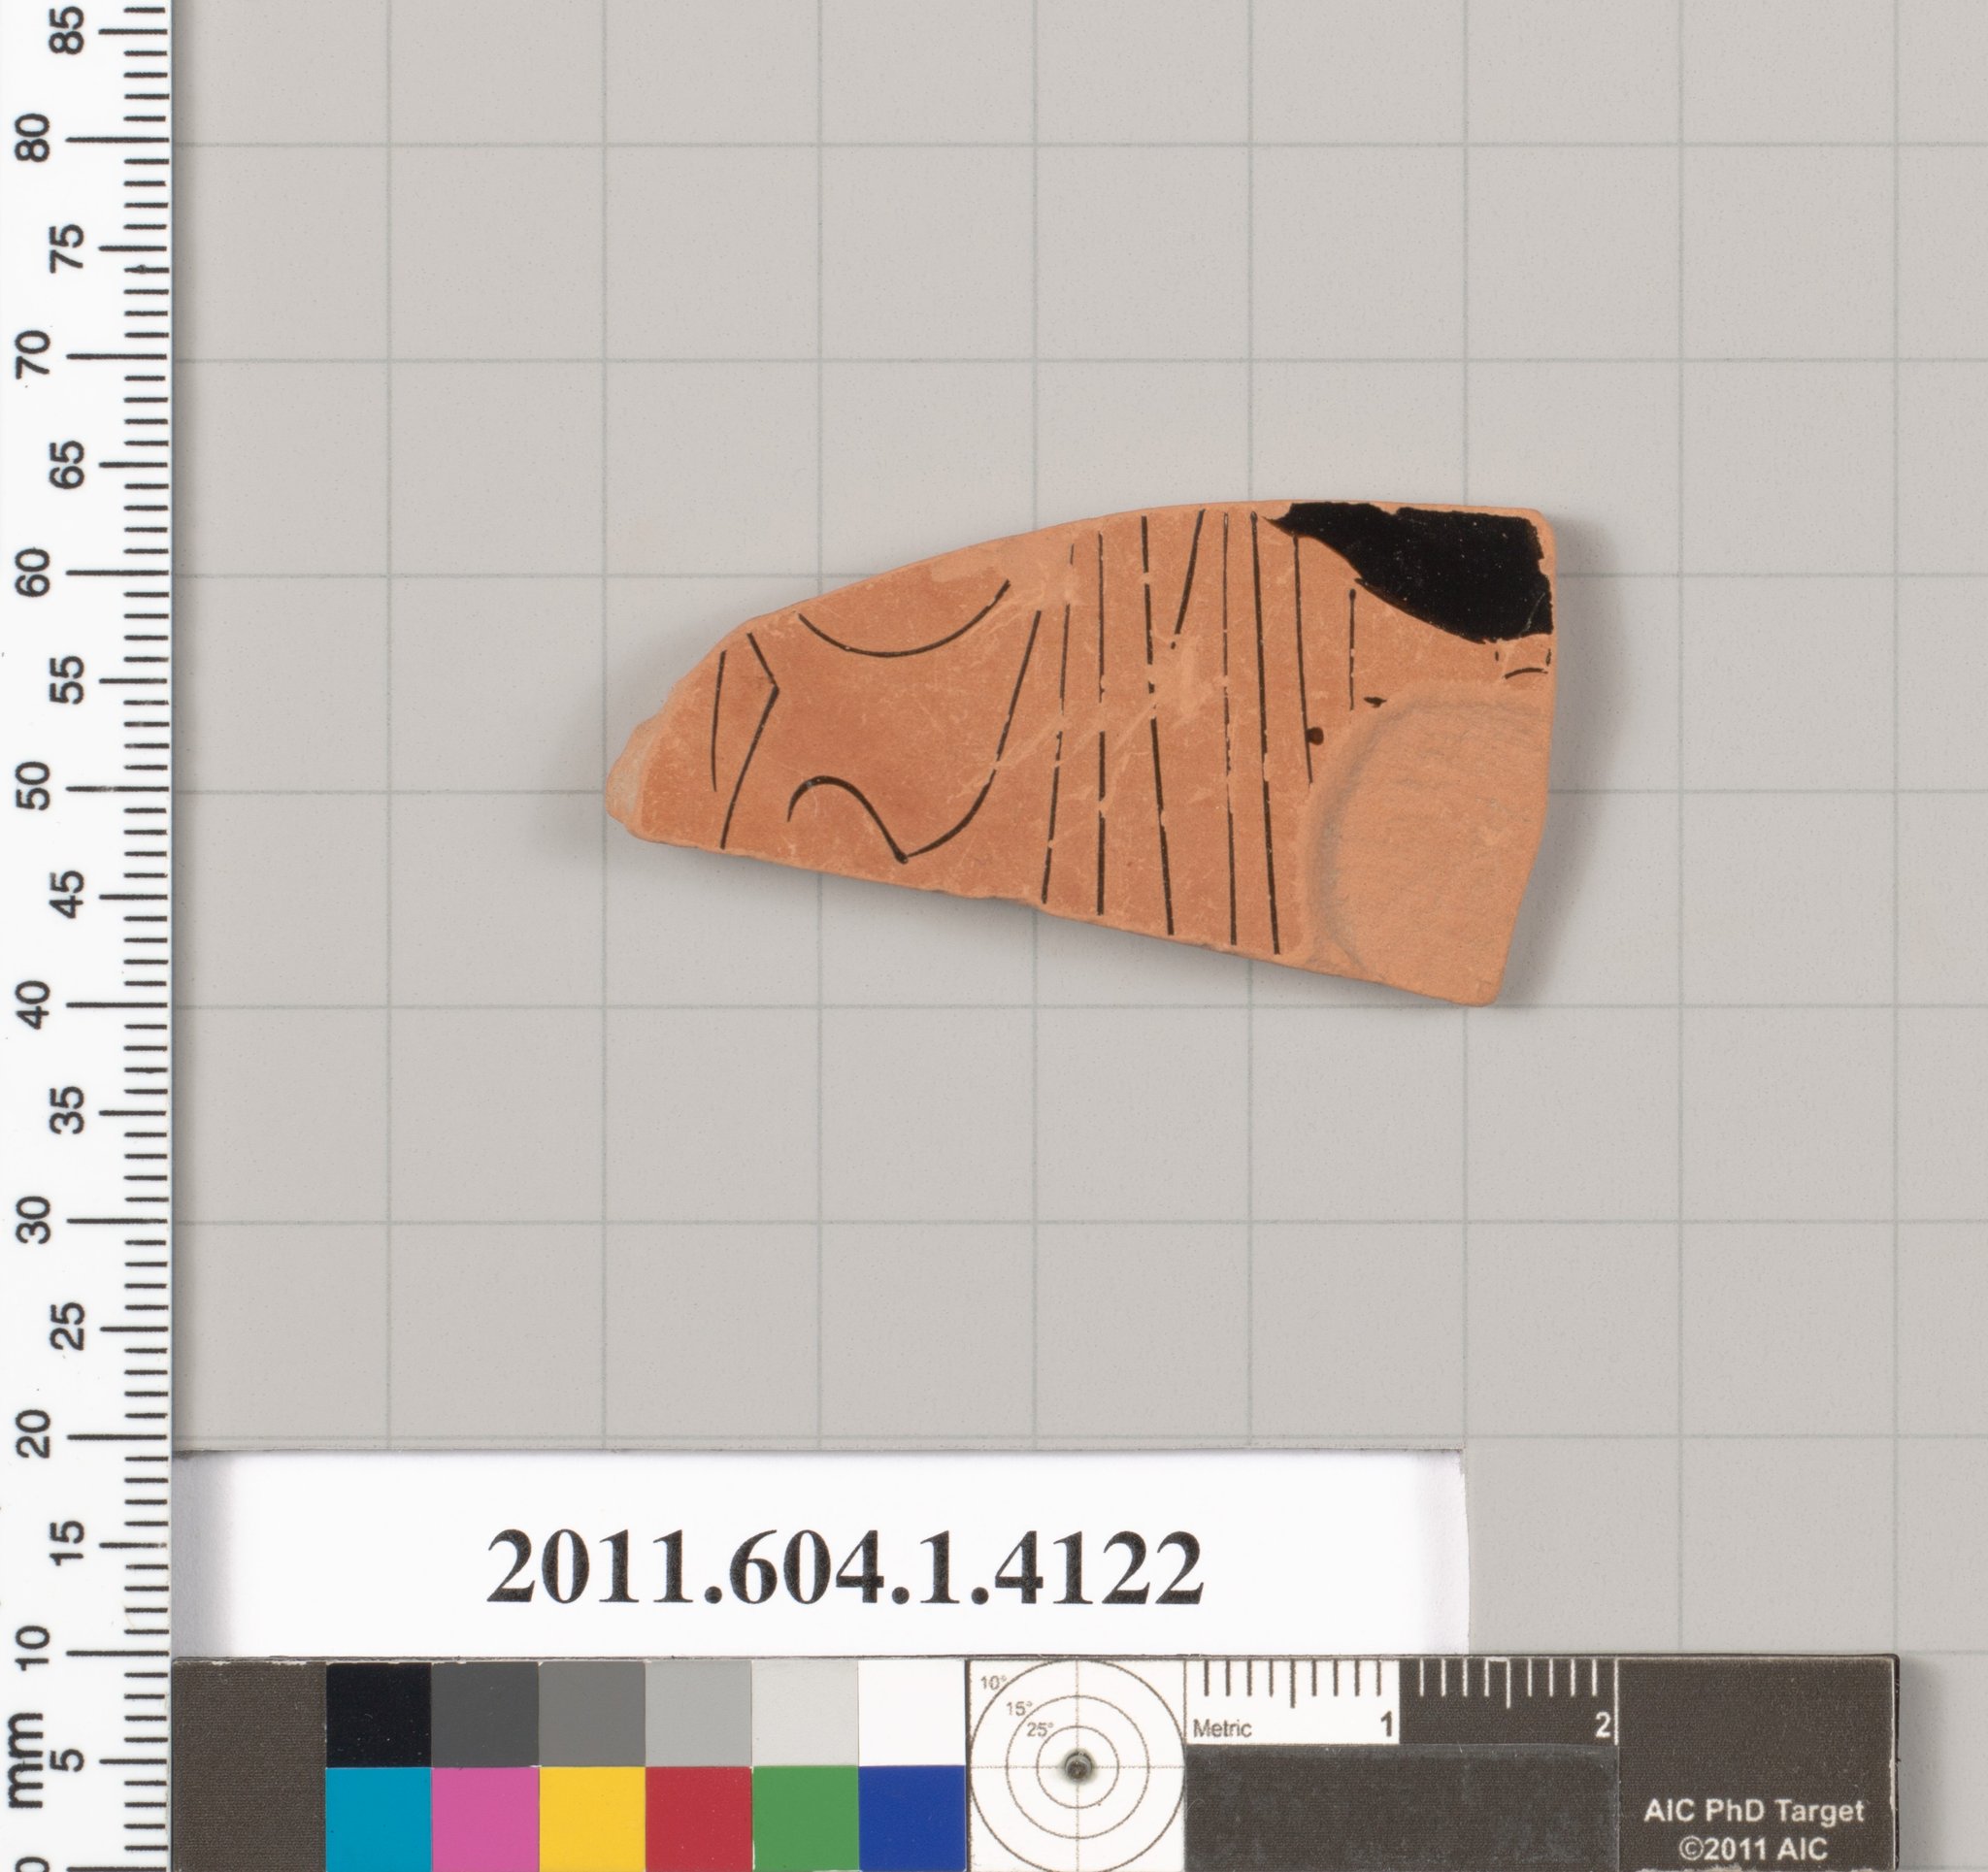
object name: kylix fragment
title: Terracotta fragment of a kylix (drinking cup)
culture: greek, attic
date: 475-451 BCE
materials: terracotta